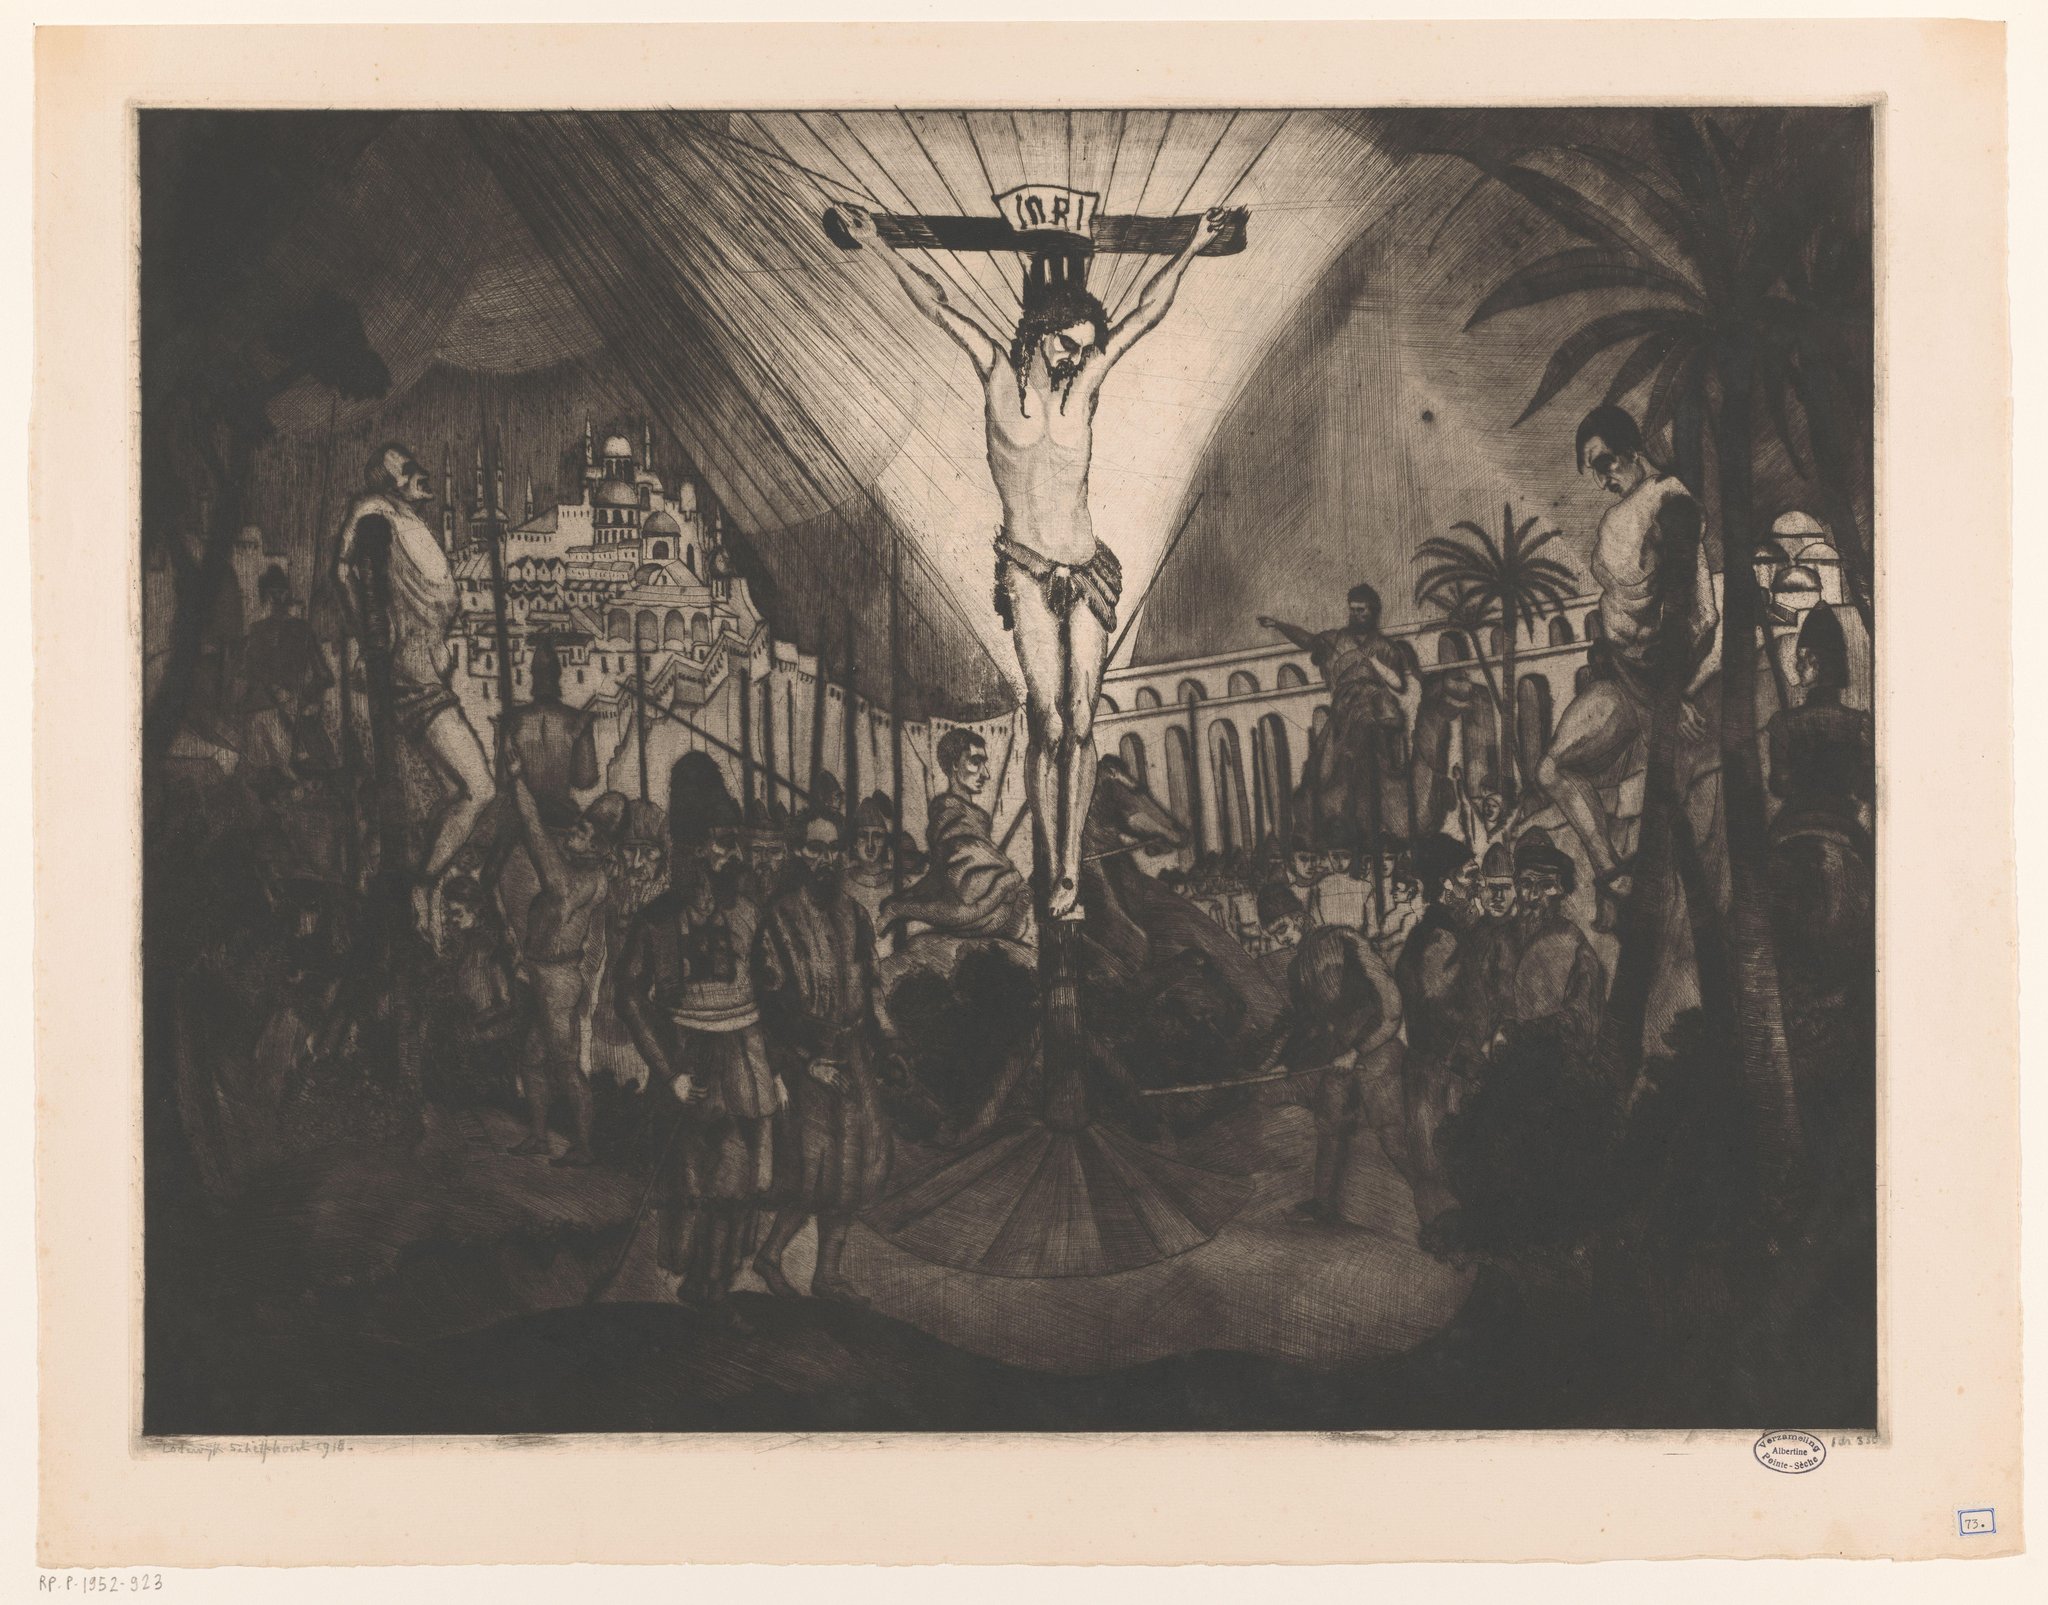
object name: print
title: Golgotha II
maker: lodewijk schelfhout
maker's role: draughtsman, print maker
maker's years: 1881-1943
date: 1918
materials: paper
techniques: drypoint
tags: city-view, and landscape with man-made constructions, the crucifixion of christ: prelude to christ's death on the cross (matthew 27:34-44; mark 15:23-32; luke 23:33-43; john 19:18-24)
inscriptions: collector's mark: Lugt 2760, collector's mark: Lugt 5i, collector's mark: Lugt 2228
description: Christus en de twee misdadigers aan het kruis op de heuvel Golgota. Onder hen soldaten met lansen, ruiters te paard en een man op een kameel. Op de achtergrond twee gedeelten van een stad die onderling verbonden zijn met een brug.